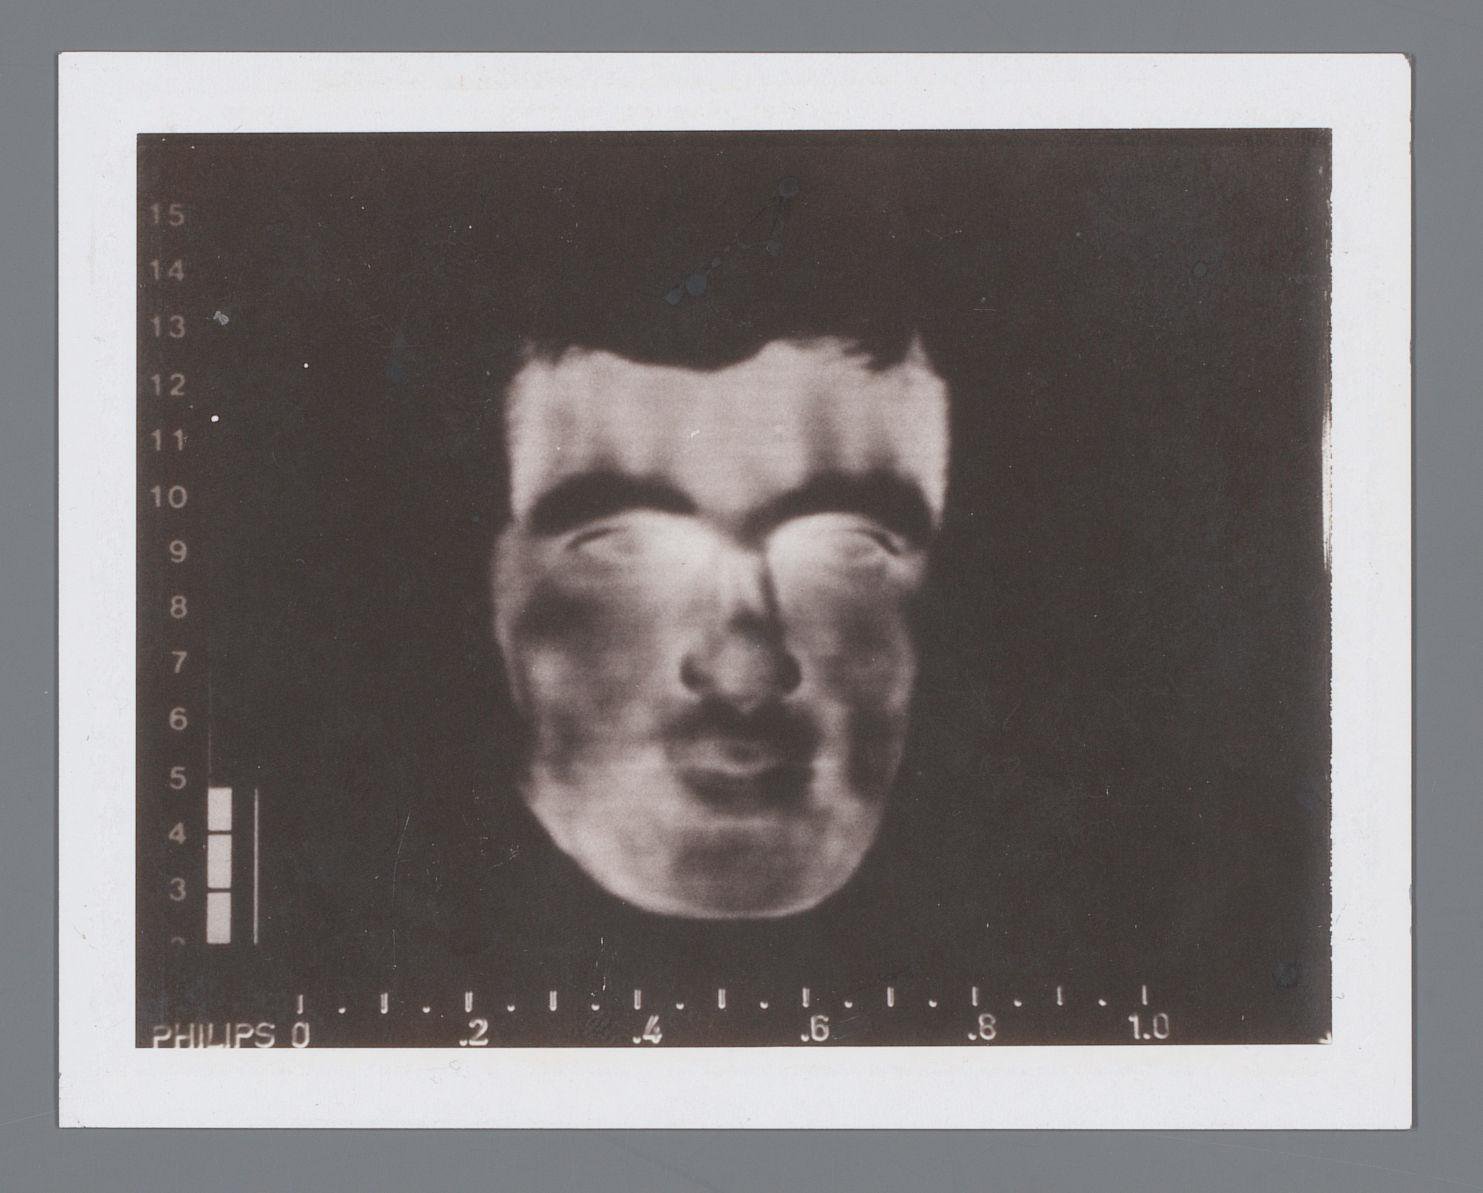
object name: instant photograph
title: Thermogram van een menselijk hoofd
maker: Anonymous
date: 1950-1984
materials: paper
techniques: dye diffusion transfer print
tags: head (human)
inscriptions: inscription: ‘Kohan/ 970-70 [?]’, number: ‘D7211-10’